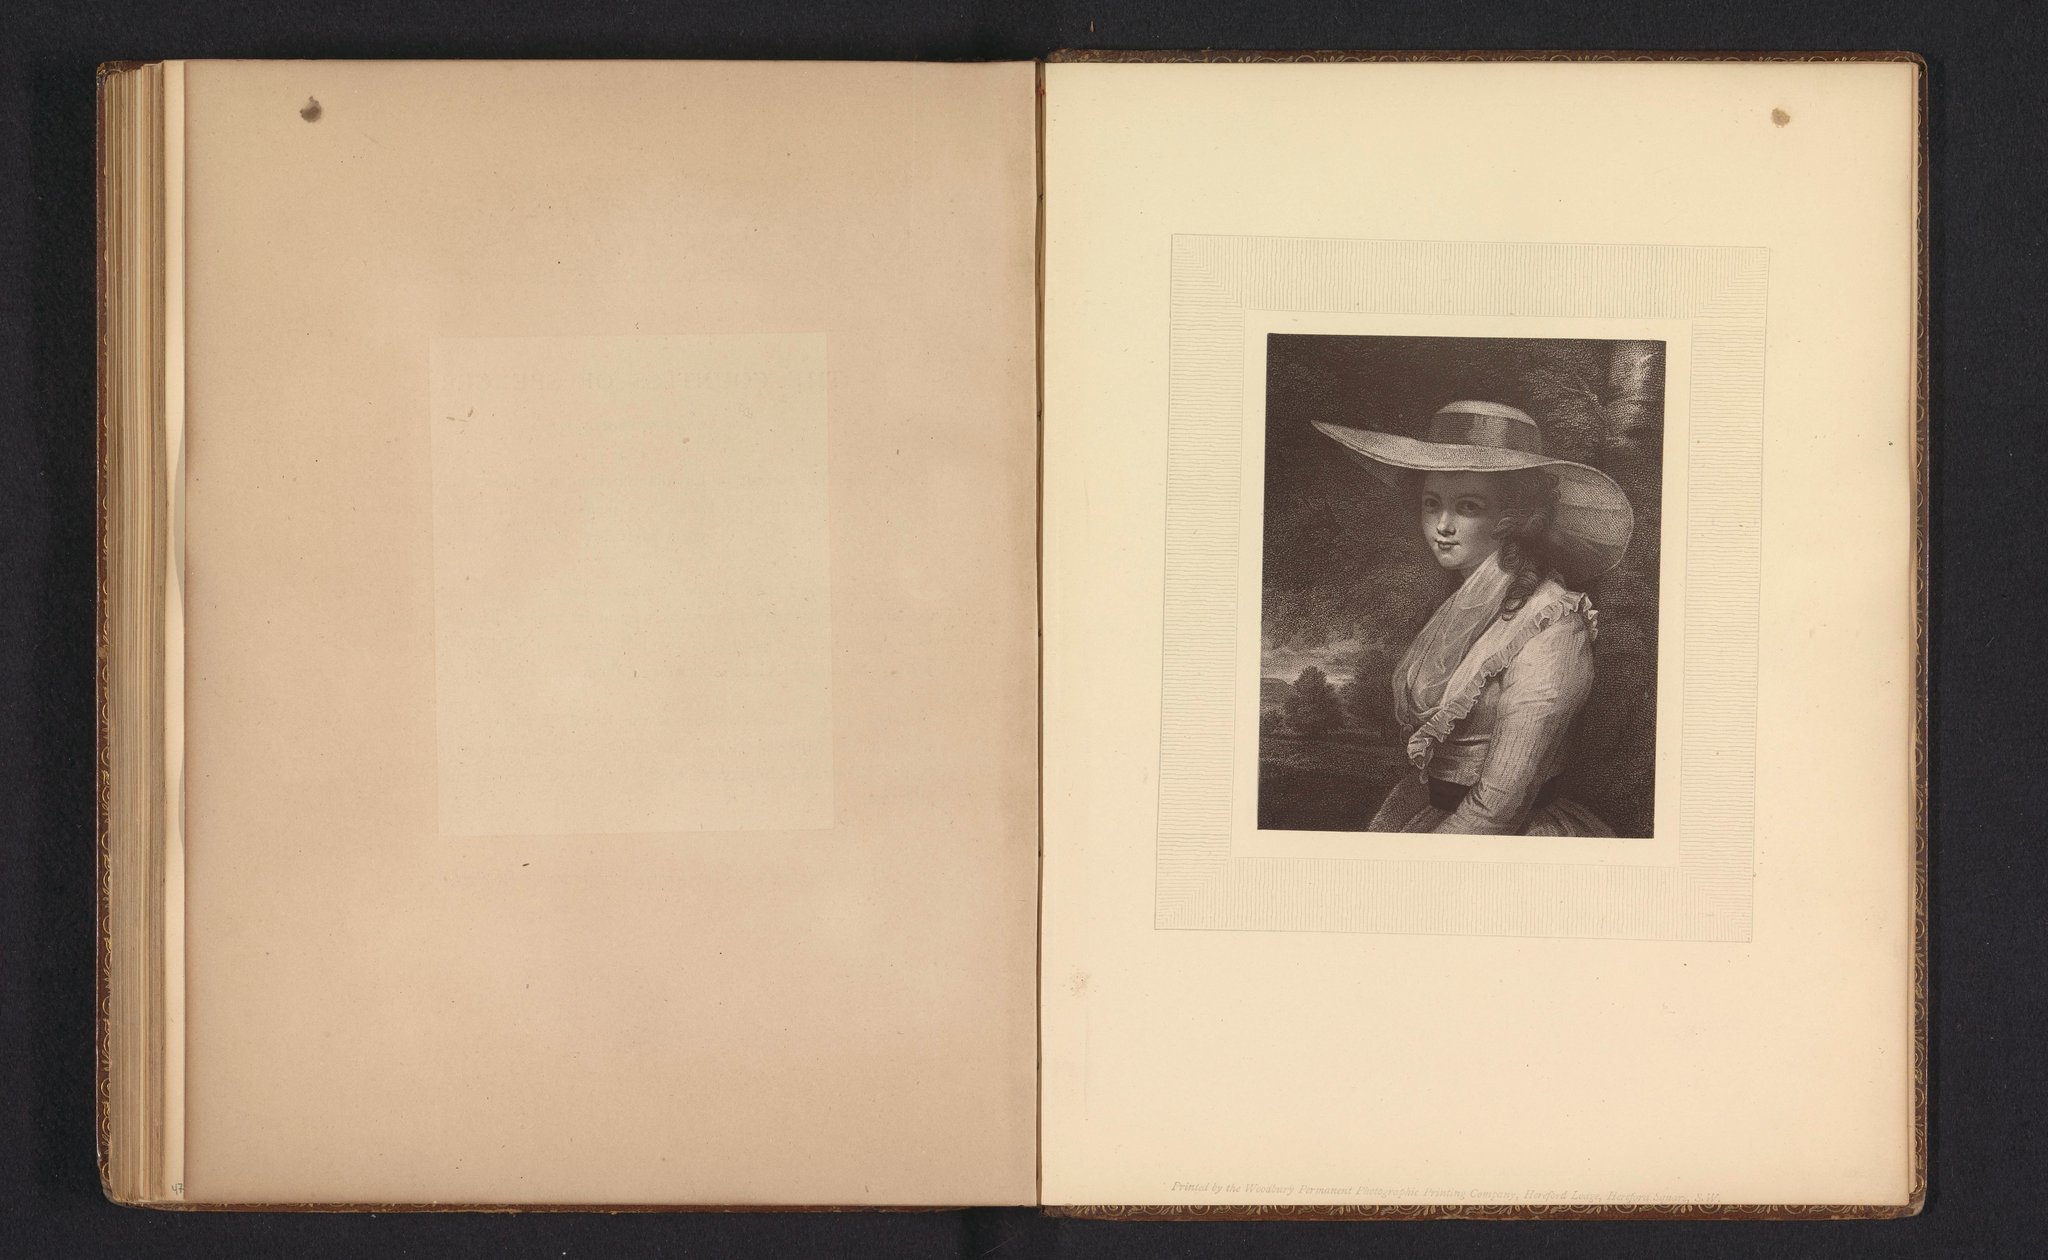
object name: reproduction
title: Fotoreproductie van een prent naar een portret van Lavinia Spencer door Joshua Reynolds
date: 1864-1874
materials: paper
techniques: woodburytype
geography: london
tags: lavinia spencer, picture, painting